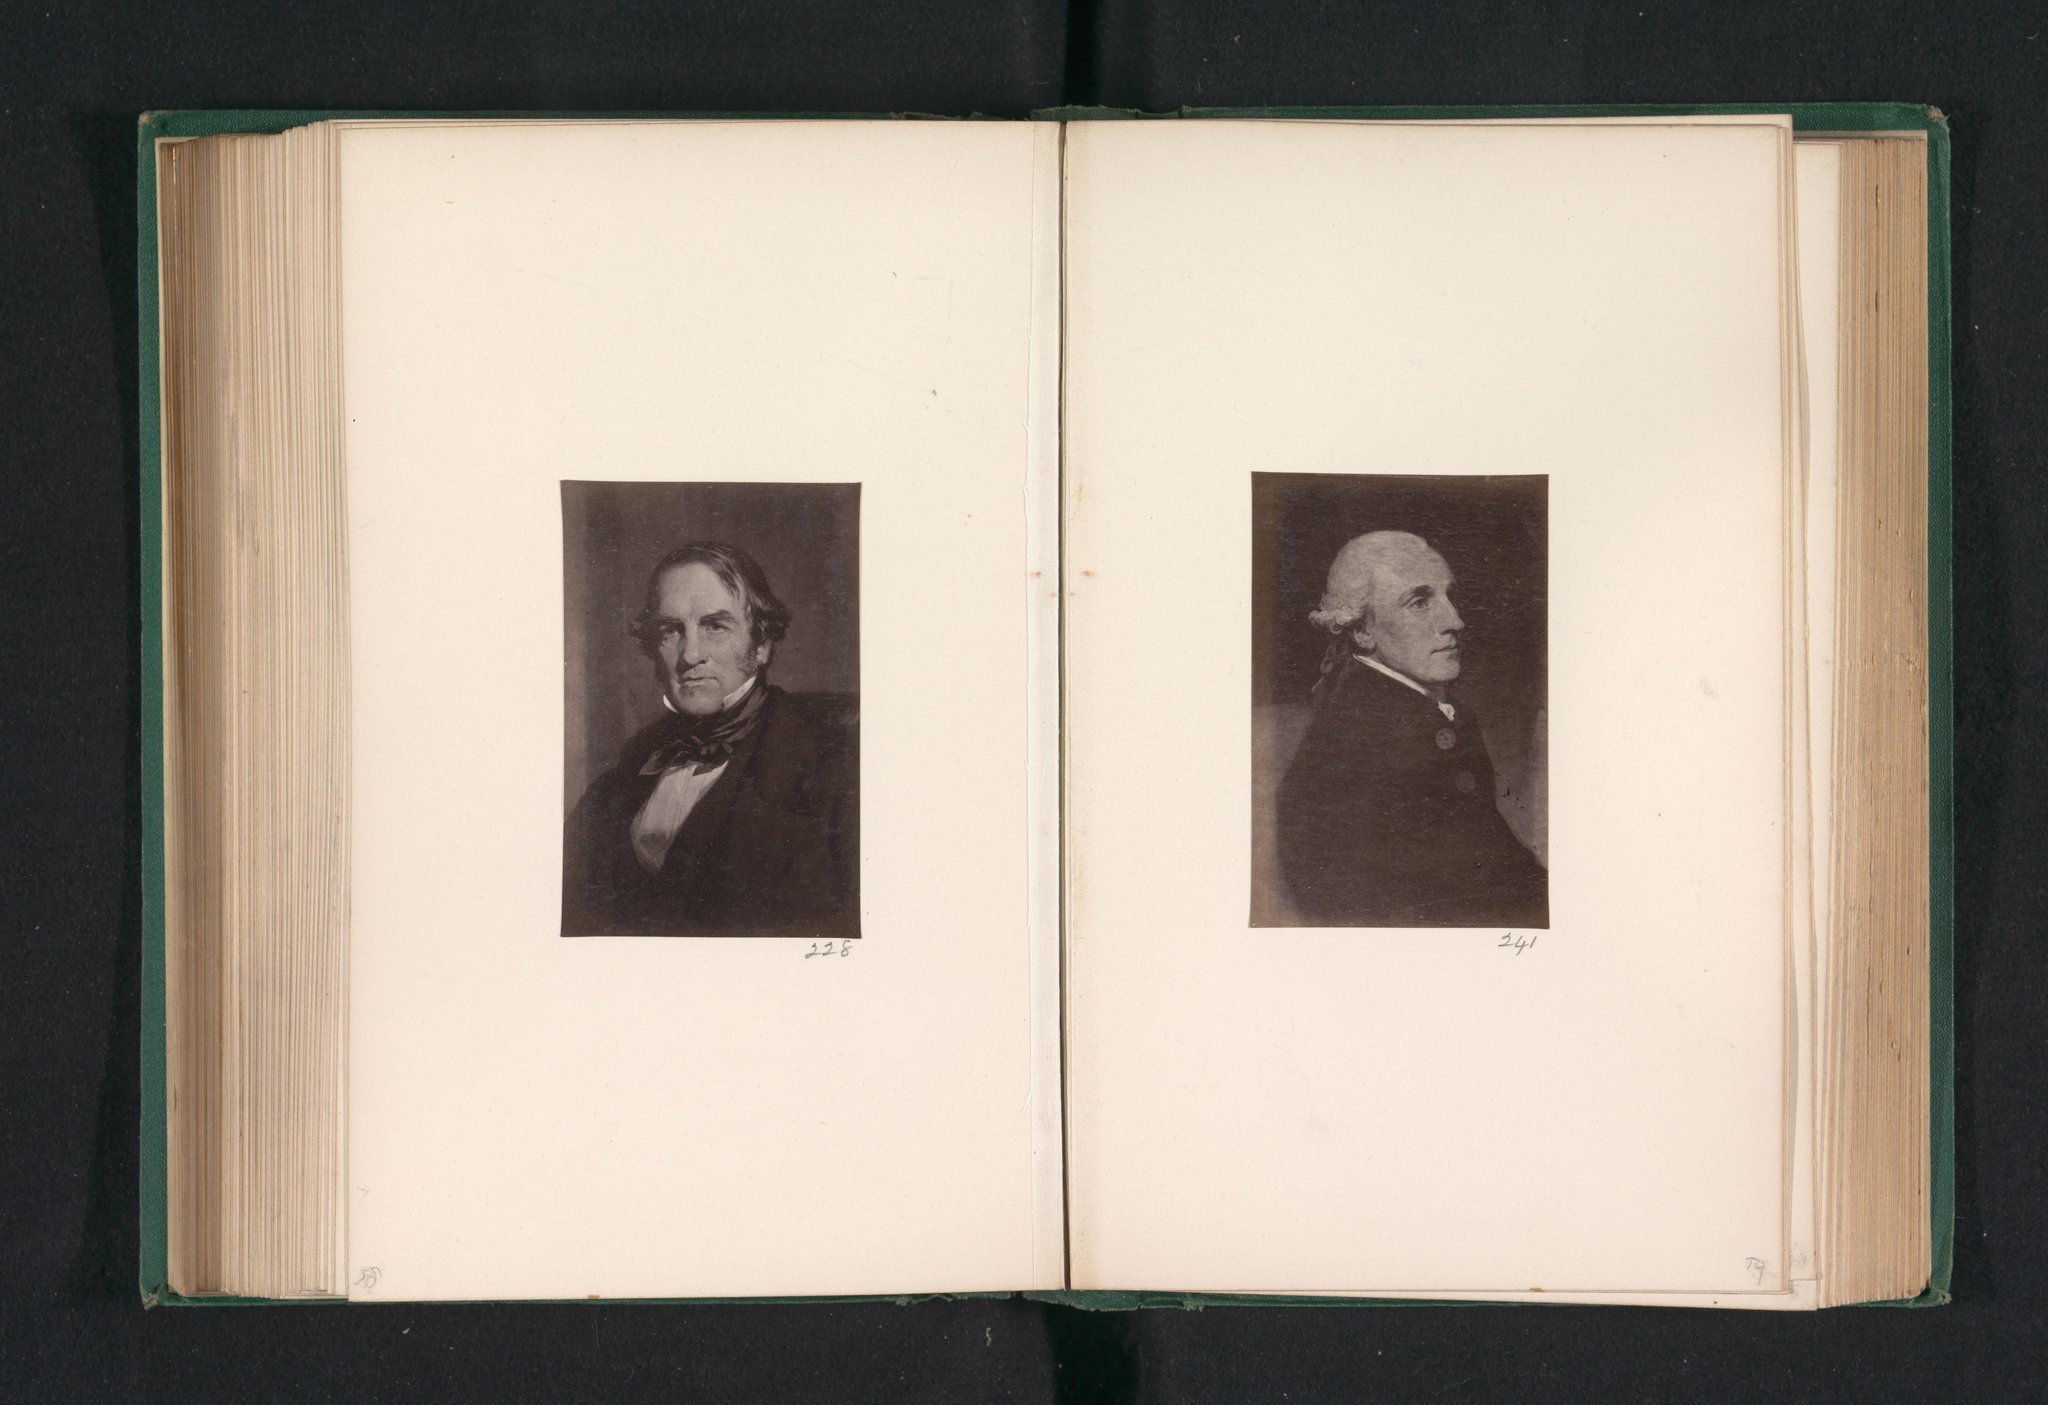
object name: photograph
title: Fotoreproductie van een schilderij, voorstellende een portret van James A. Anderson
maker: thomas annan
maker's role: fotograaf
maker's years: 1829-1887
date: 1863-1868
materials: photographic support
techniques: albumen print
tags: historical persons (portraits and scenes from the life) (+ (full) bust portrait)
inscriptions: number: ‘228’